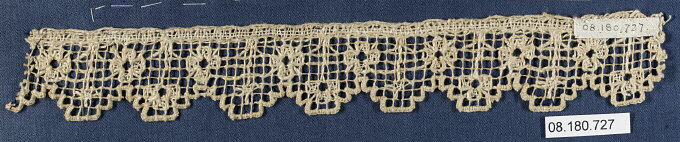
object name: fragment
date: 1801-1900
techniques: embroidery